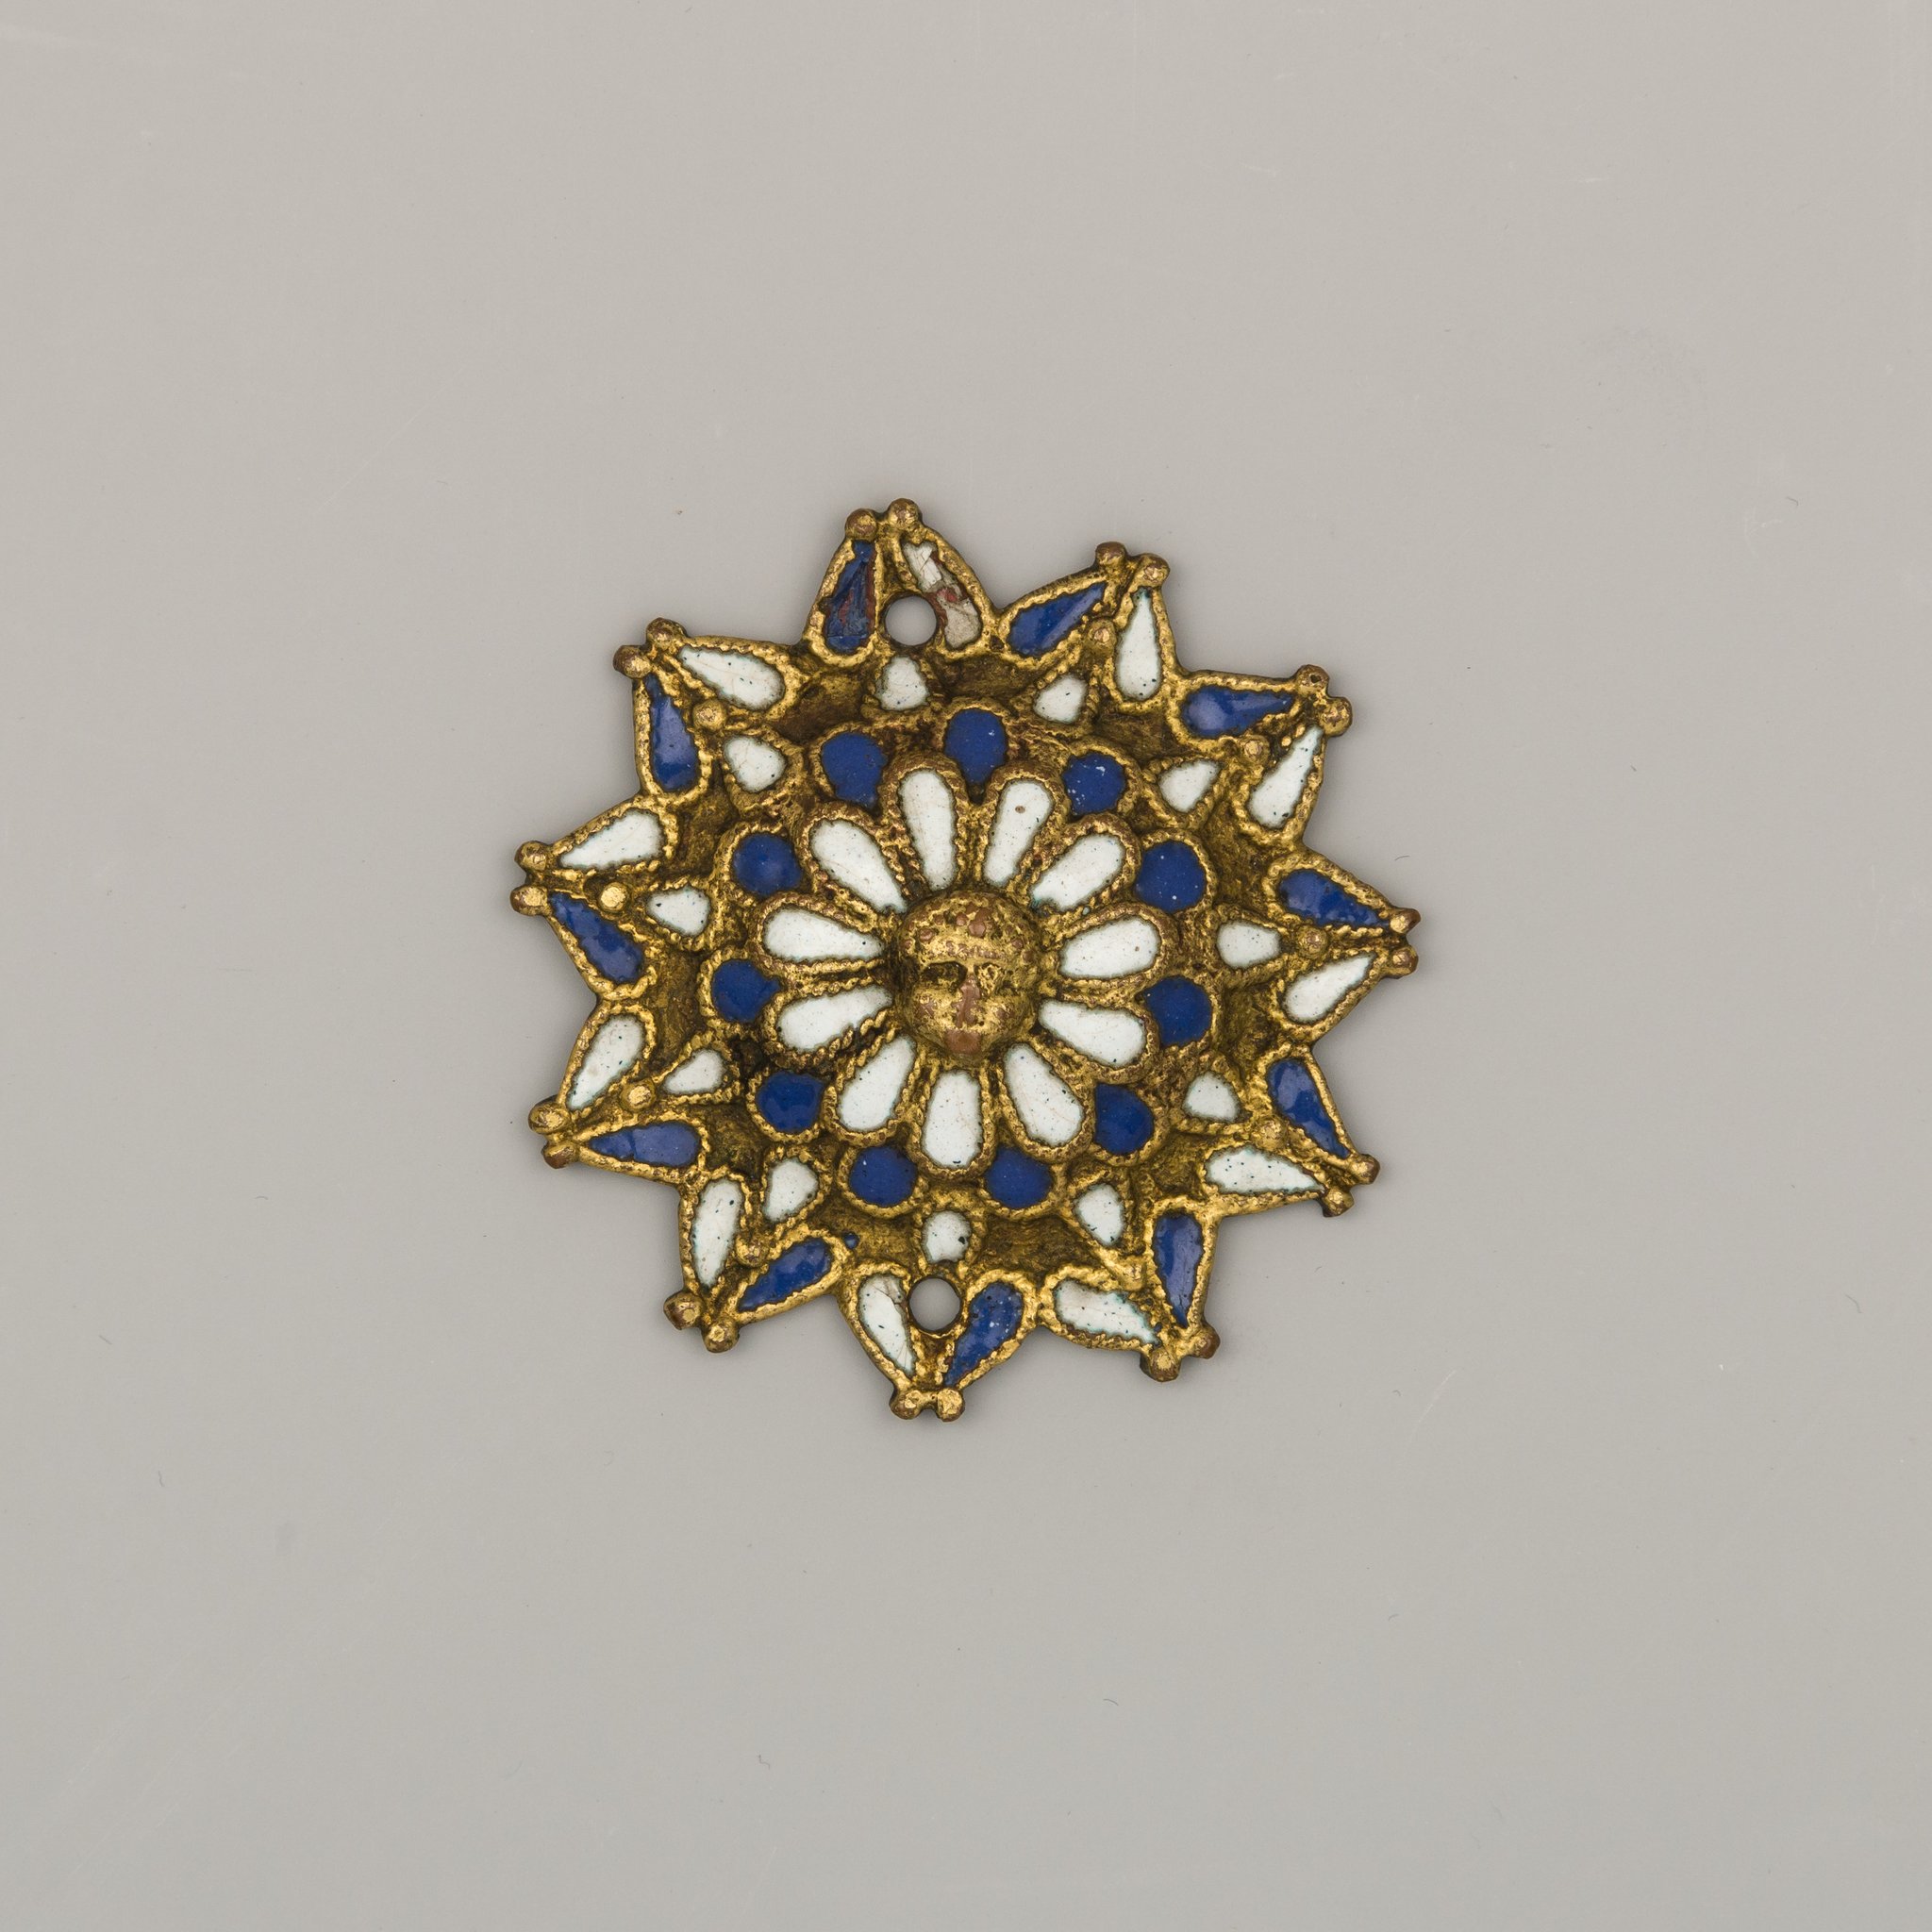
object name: bit bos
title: Pair of Bit Bosses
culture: italian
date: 1600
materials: copper alloy, enamel, gold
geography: italy